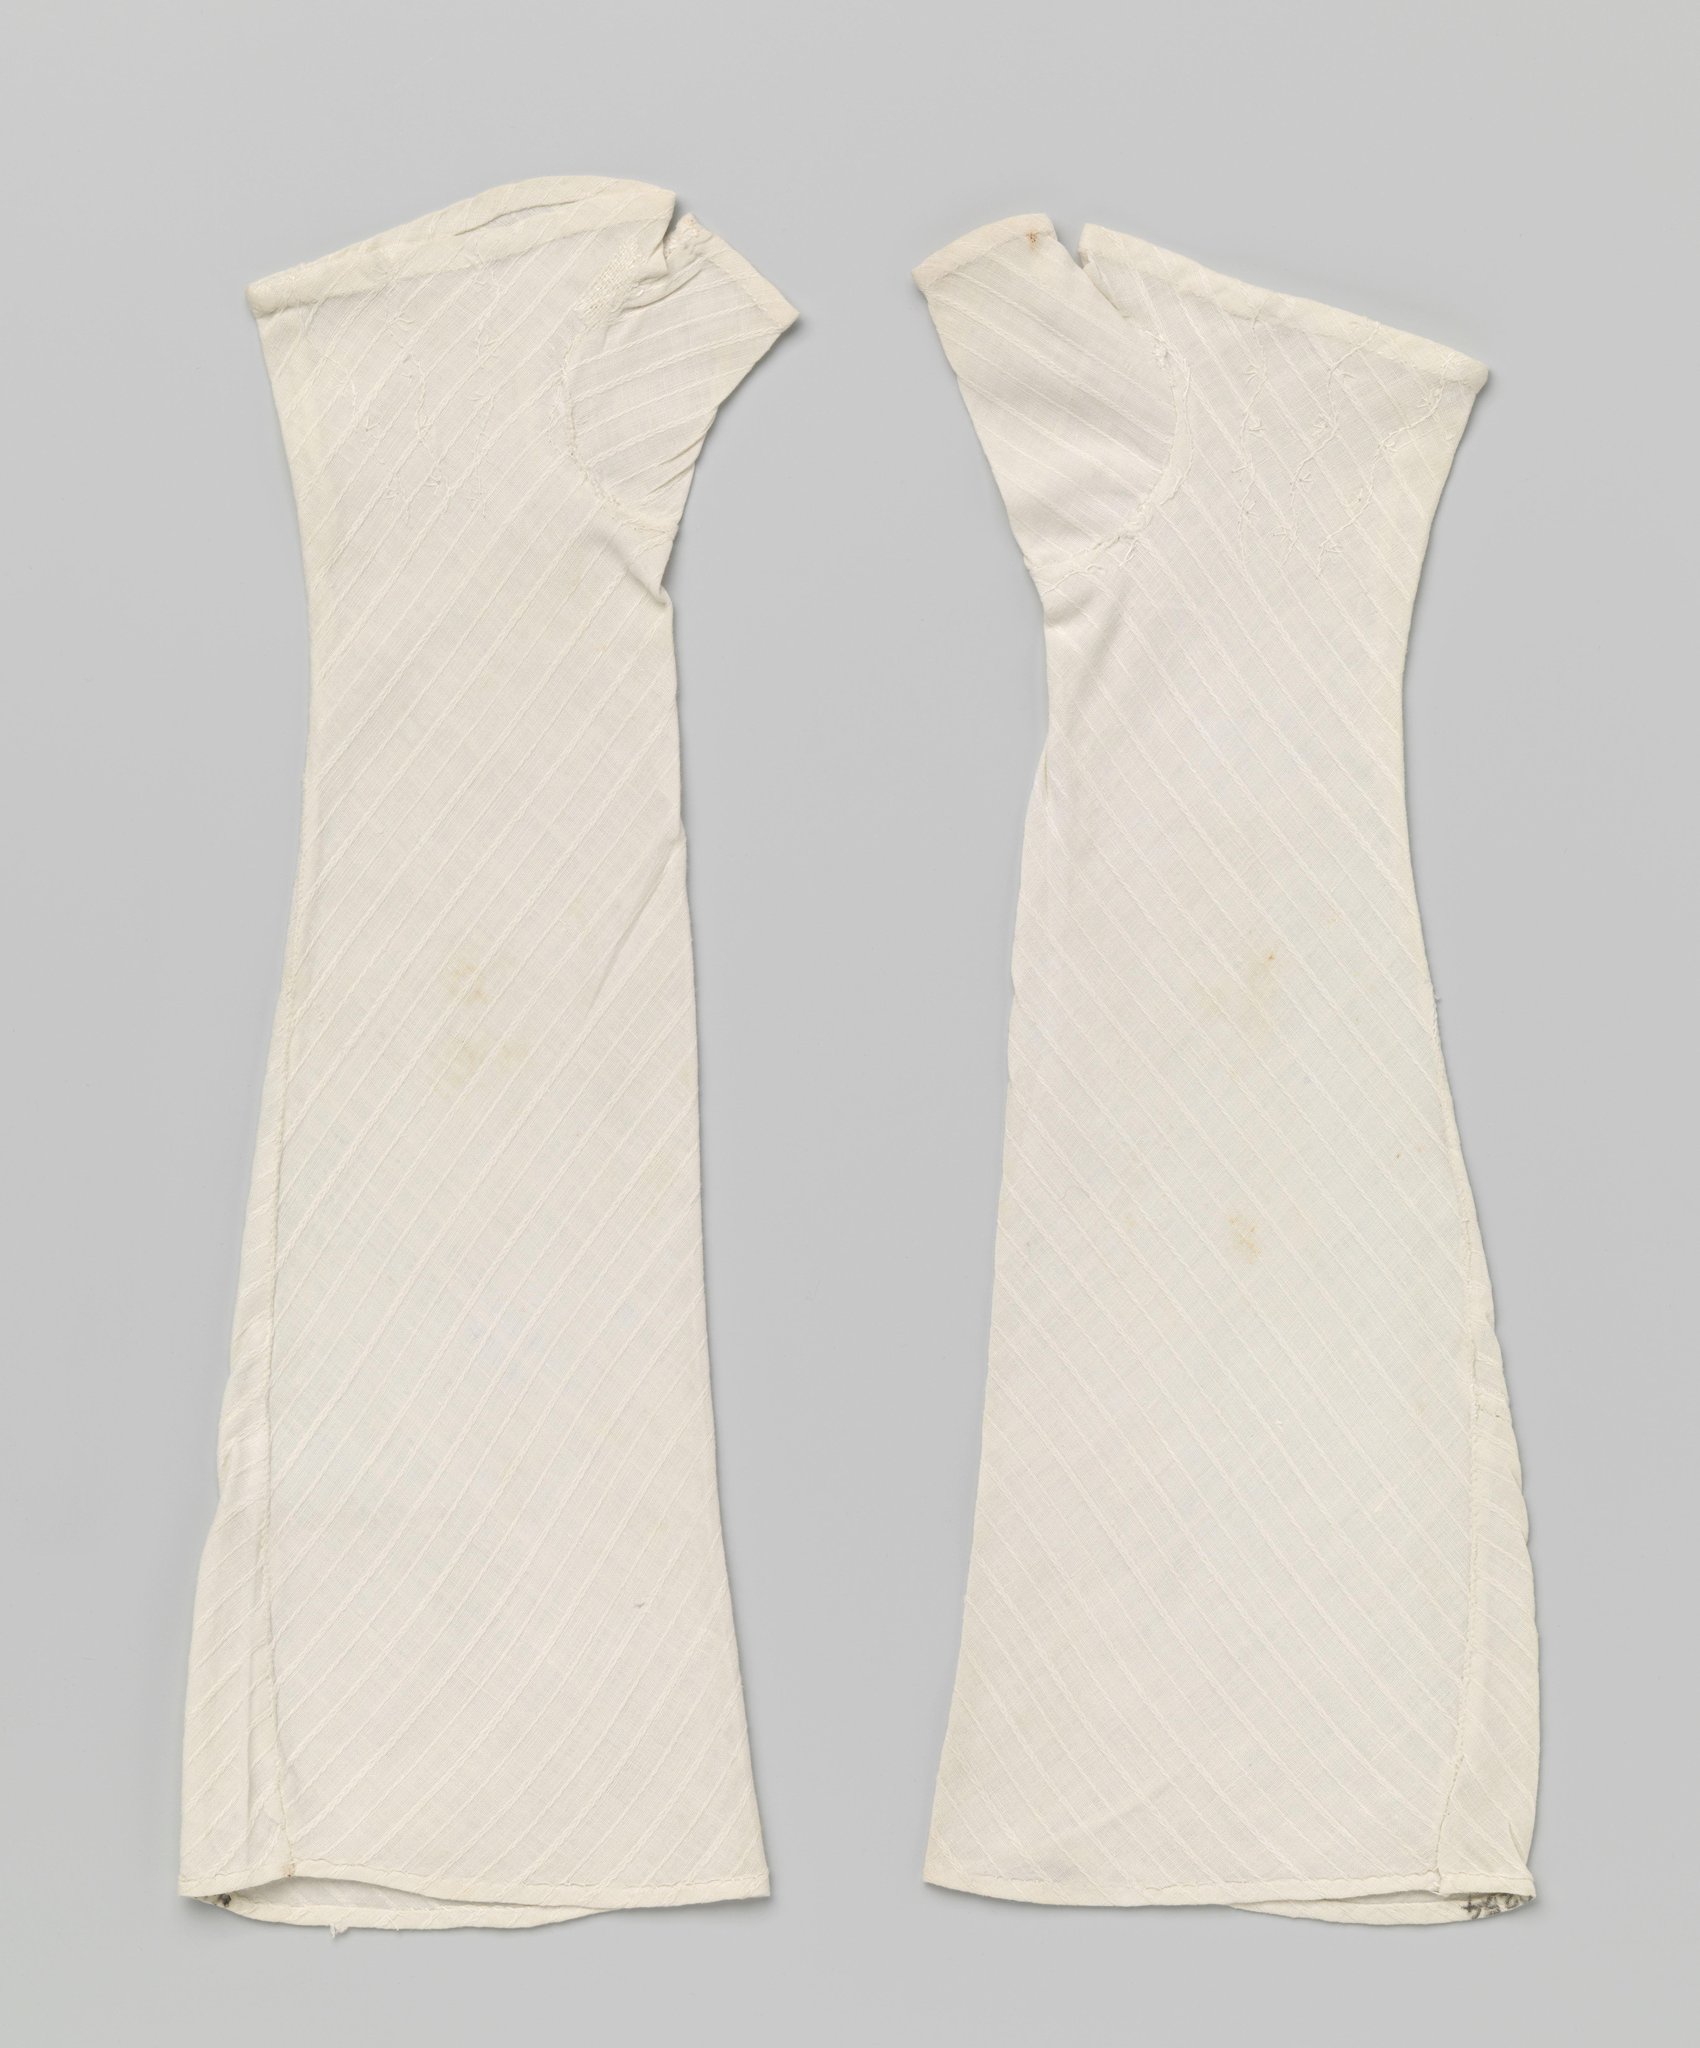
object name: clothing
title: Mitaine van witte gestreepte katoen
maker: Anonymous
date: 1880-1900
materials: cotton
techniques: embroidered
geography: western europe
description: Linker mitaine van witte gestreepte katoen. Op de rug drie geborduurde slingerlijnen.